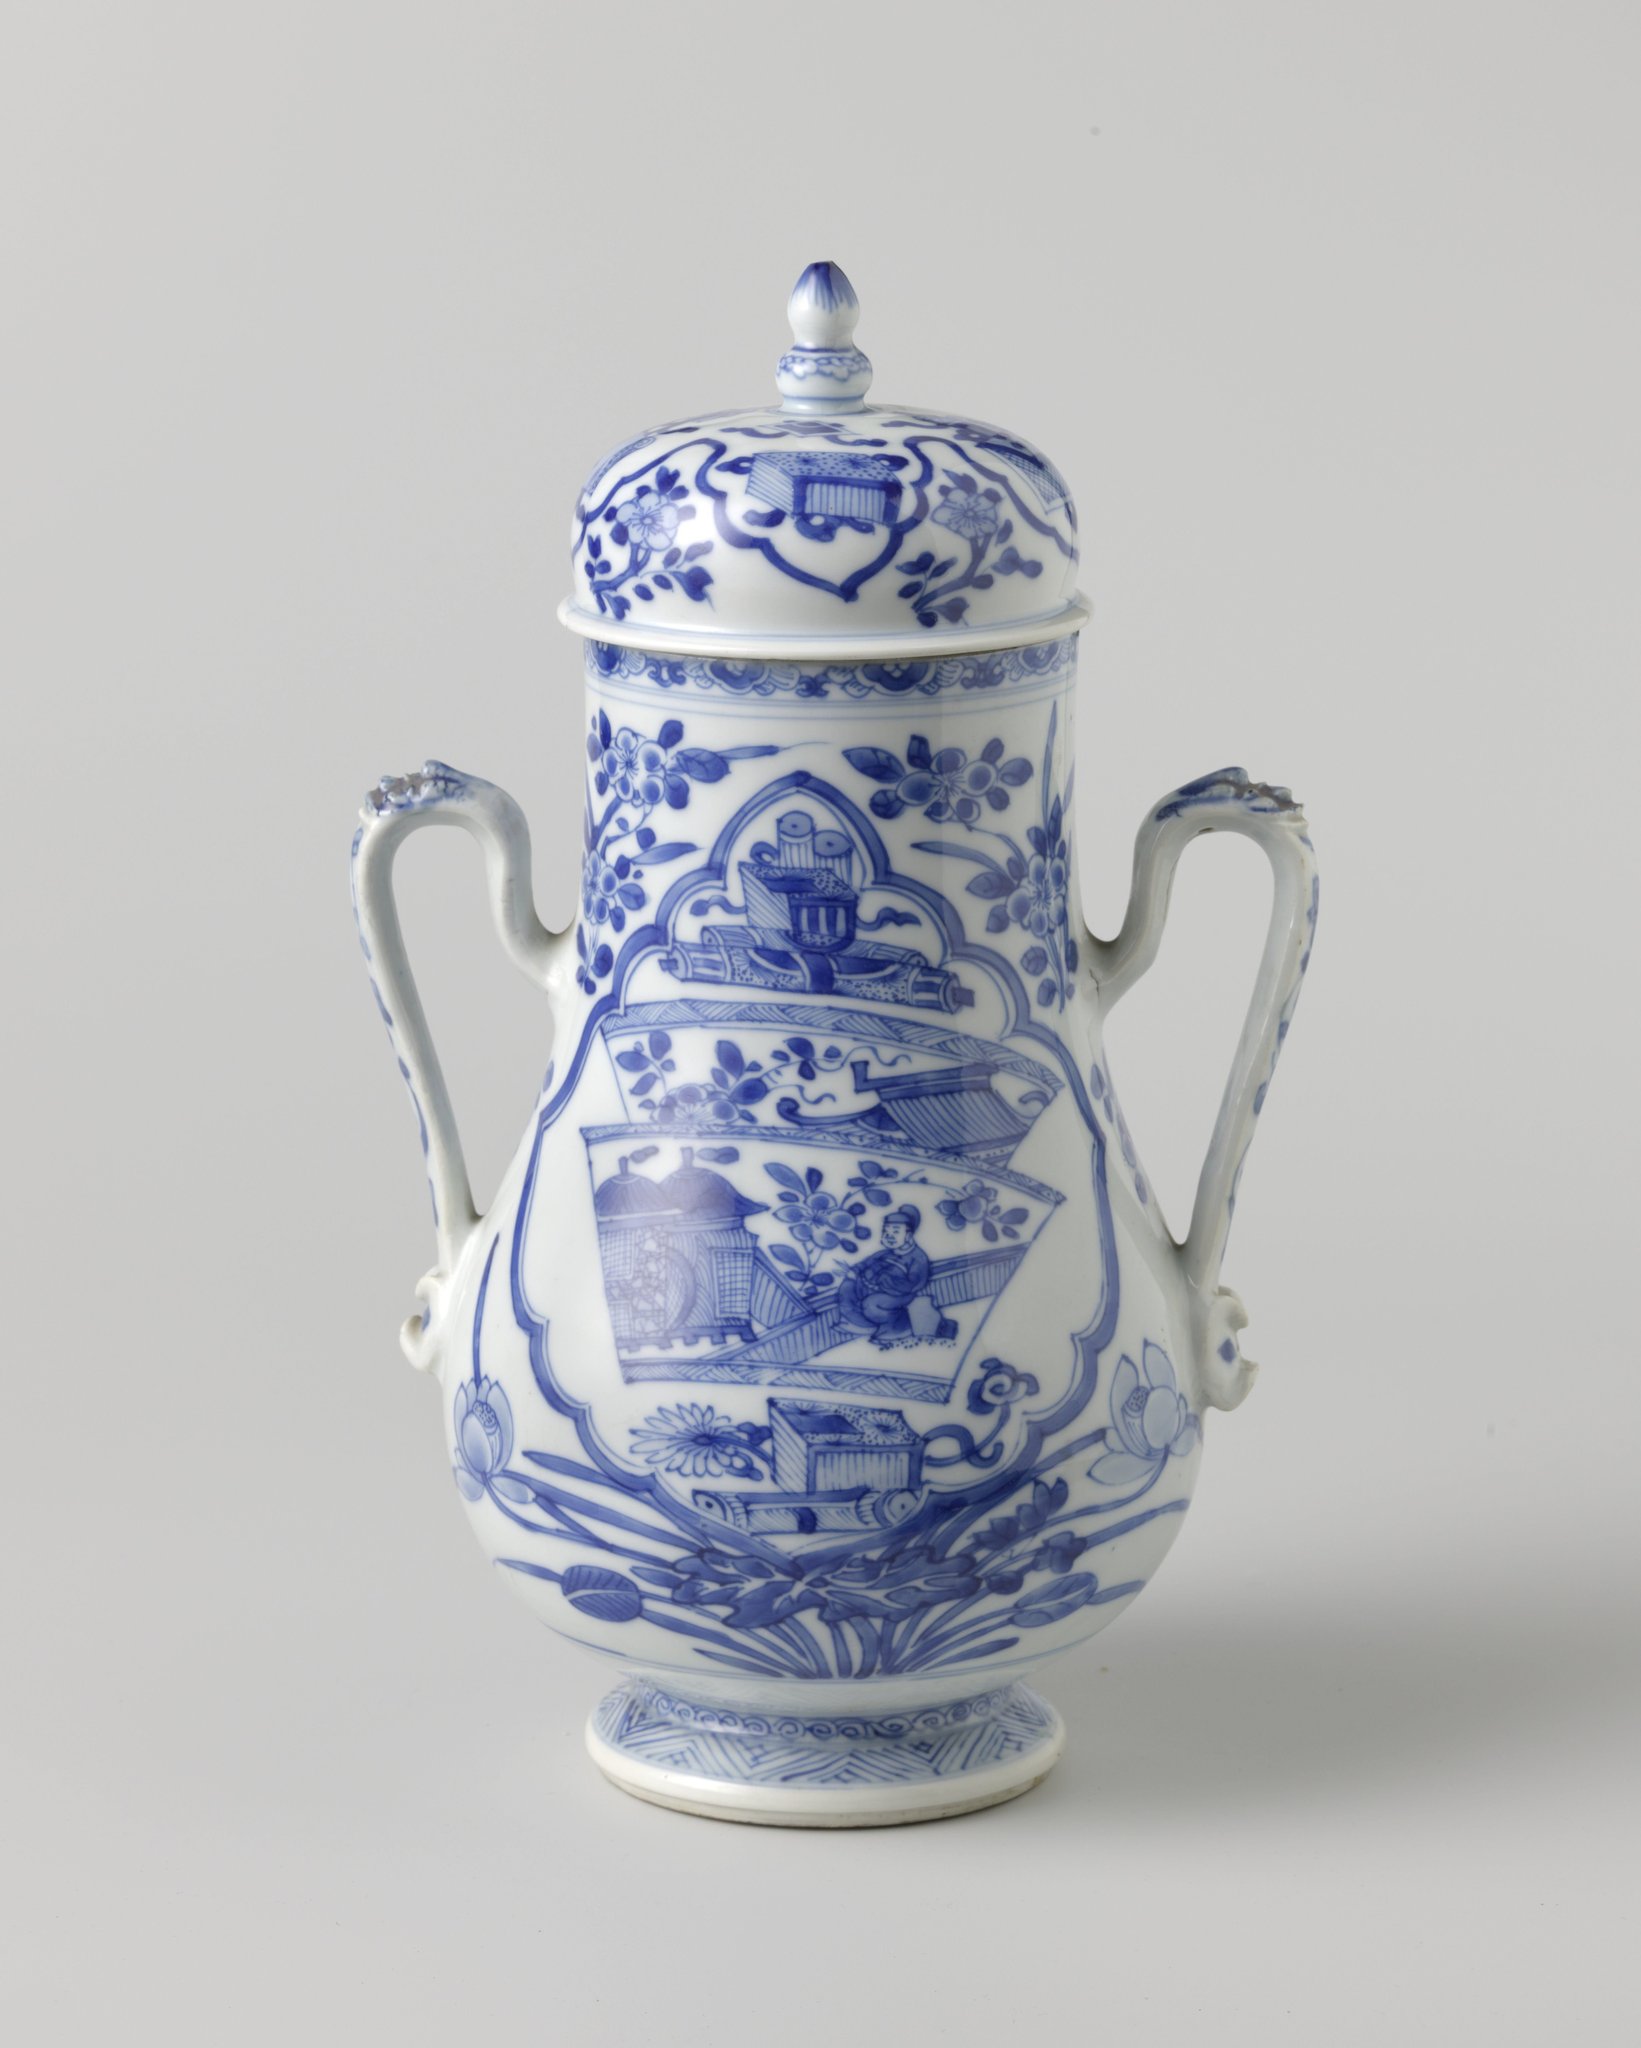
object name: dekselvaas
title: Pear-shaped covered jar with precious objects and flower sprays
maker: Anonymous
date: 1700-1724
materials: cobalt, glaze, paint, porcelain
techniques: firing, turning, vitrification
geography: china